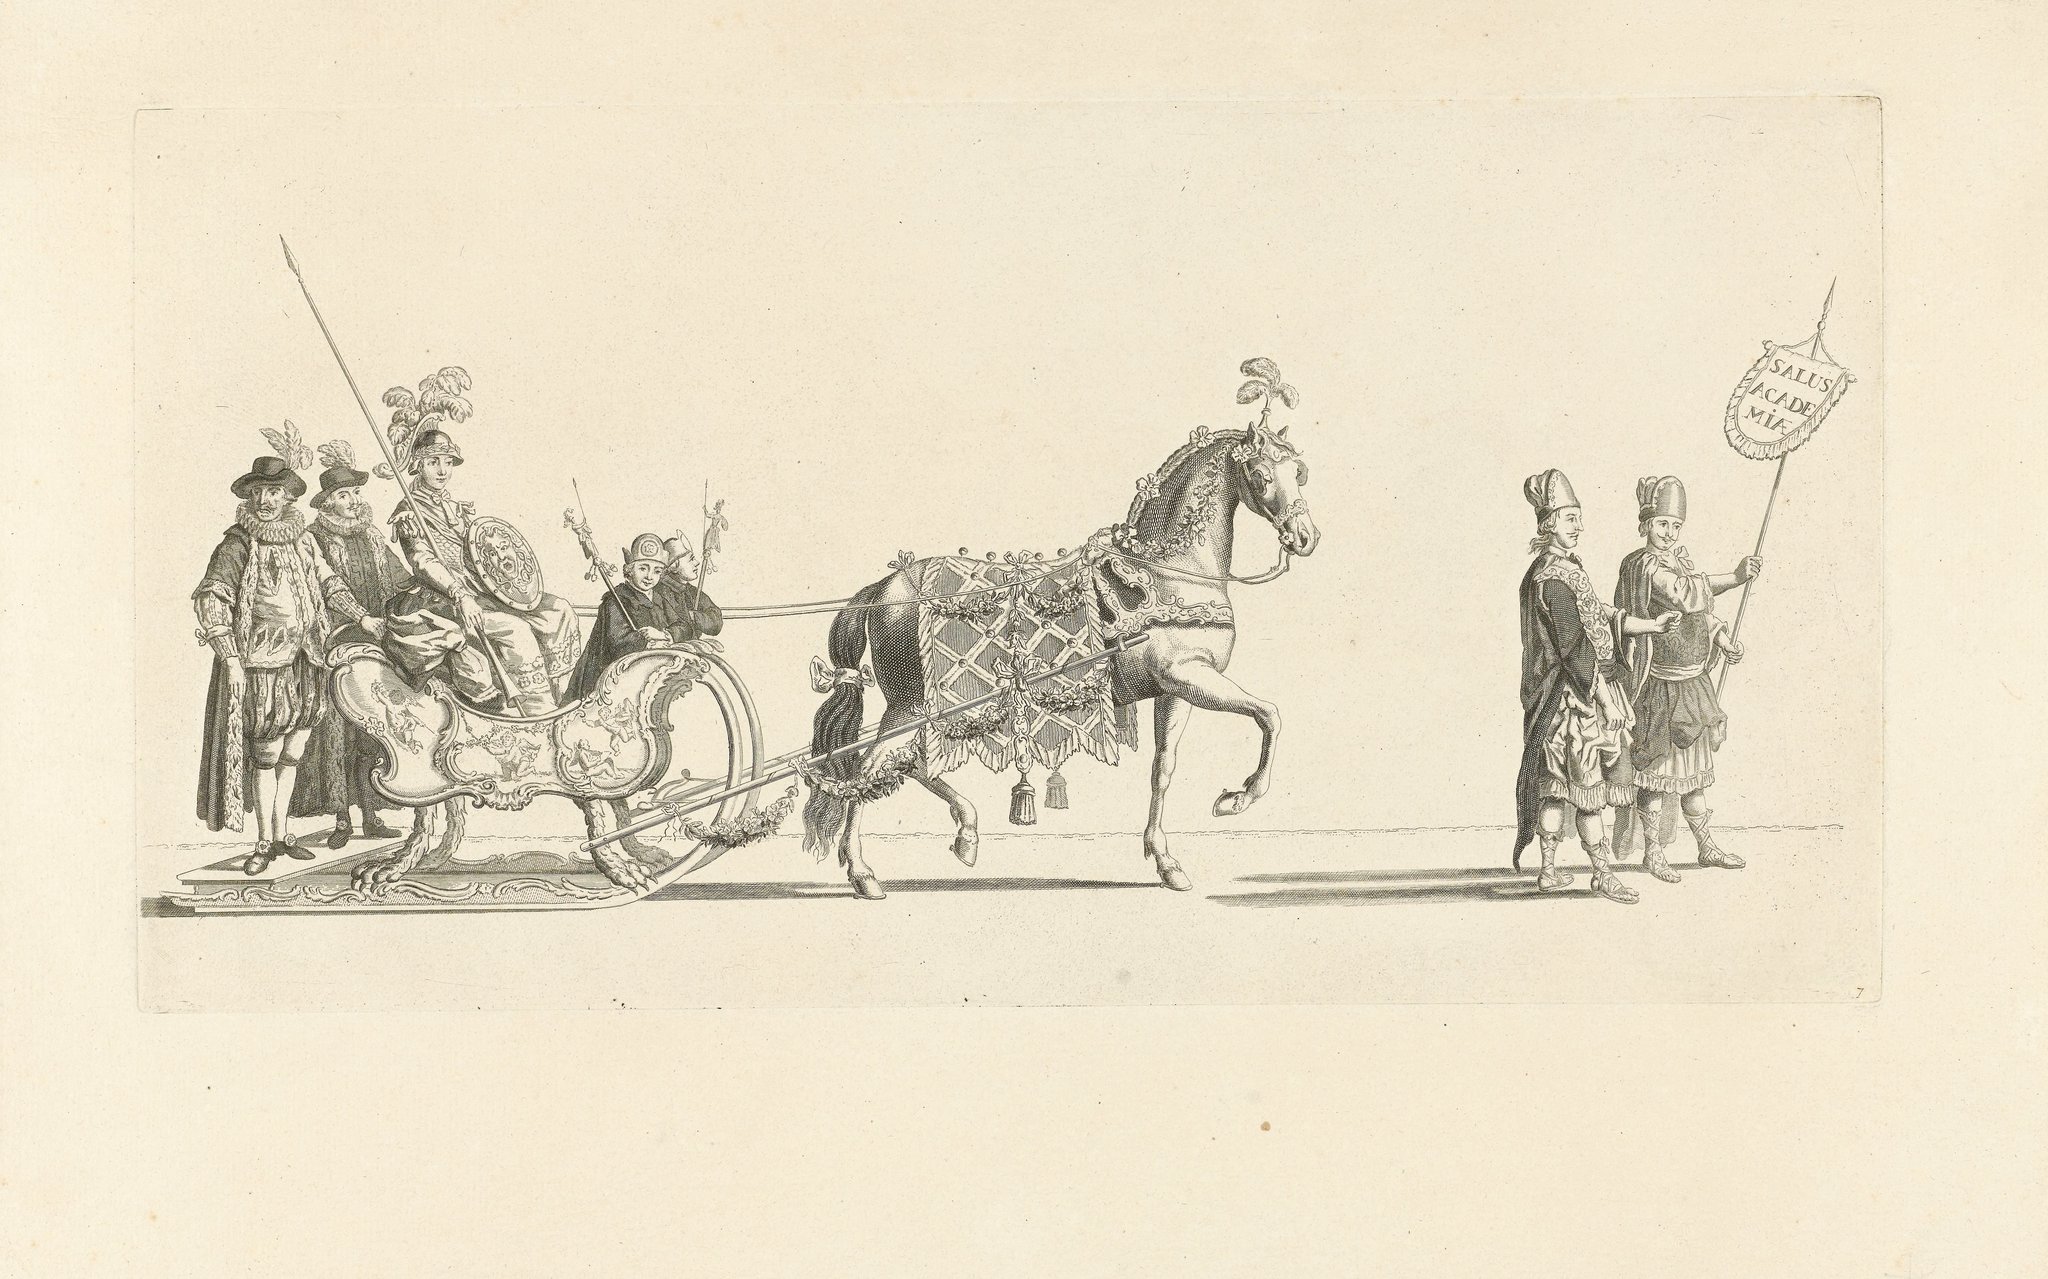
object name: print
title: Zevende slede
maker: nicolaas van der worm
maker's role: draughtsman, print maker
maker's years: 1757-1828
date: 1776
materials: paper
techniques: engraving, etching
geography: northern netherlands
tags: sledge, sleigh (winter sports), commemoration of the founding of a university, leiden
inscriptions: inscription: ‘Danl: Hendk: Righout’ Lugt Signatuur van Daniel Henricus Righout, de secretaris van het genootschap, als bewijs van echtheid., collector's mark: 2228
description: De zevende slede in de optocht. Een slede met Minerva getrokken door een paard en voorafgegaan door twee personen in Griekse kleding. Onderdeel van een reeks van twaalf platen van de sledevaart op 24 januari 1776 georganiseerd door het Leidse genootschap Veniam Pro Laude bij gelegenheid van het Tweede Eeuwfeest van het Leids Ontzet (3 oktober 1574) en de oprichting van de Universiteit van Leiden (8 februari 1575).